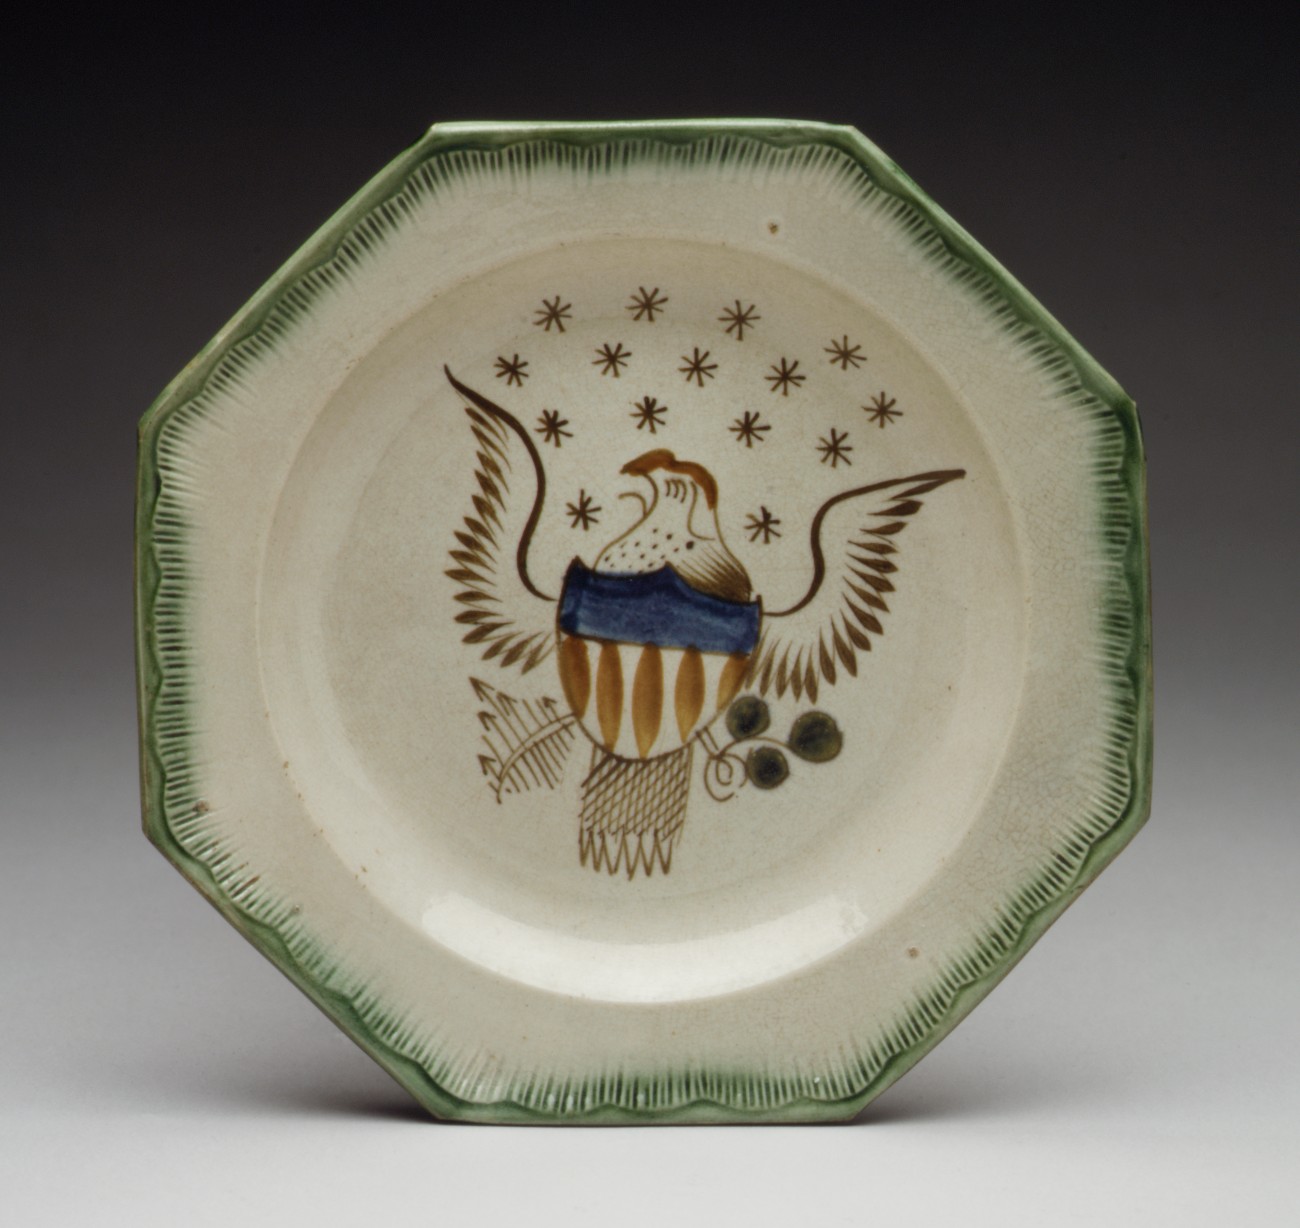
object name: plate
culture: british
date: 1800-1830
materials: earthenware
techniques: transfer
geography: england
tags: eagles